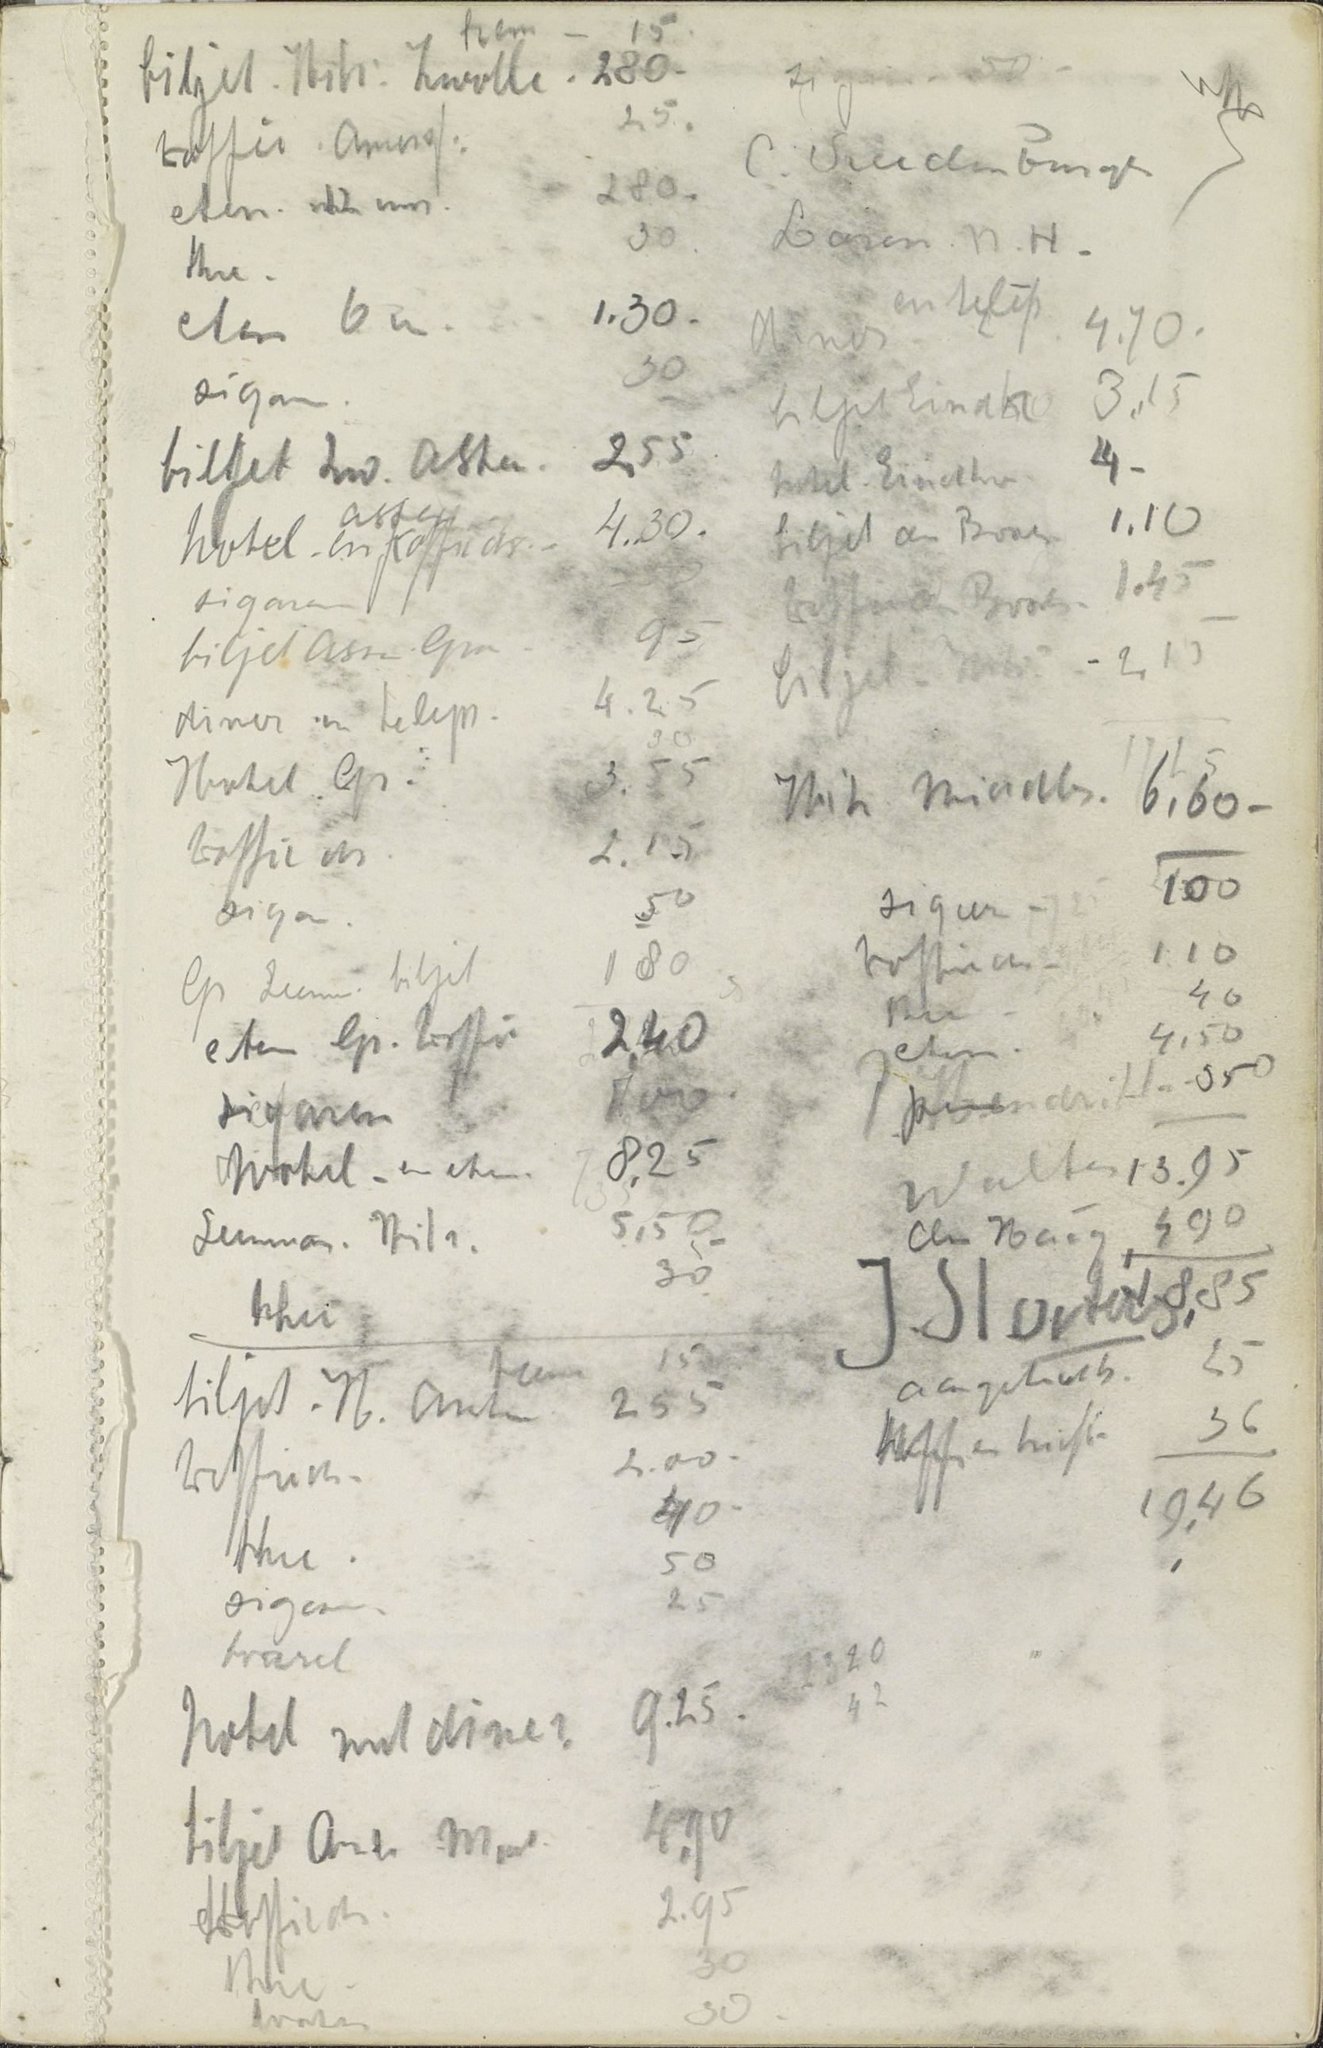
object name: sketchbook leaf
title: Lijst van uitgaven en kosten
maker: cornelis vreedenburgh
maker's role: draughtsman, print maker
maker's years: 1880-1946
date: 1890-1946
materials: paper, pencil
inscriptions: annotation: ‘[...]’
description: Blad 1 recto uit een schetsboek met 50 bladen.